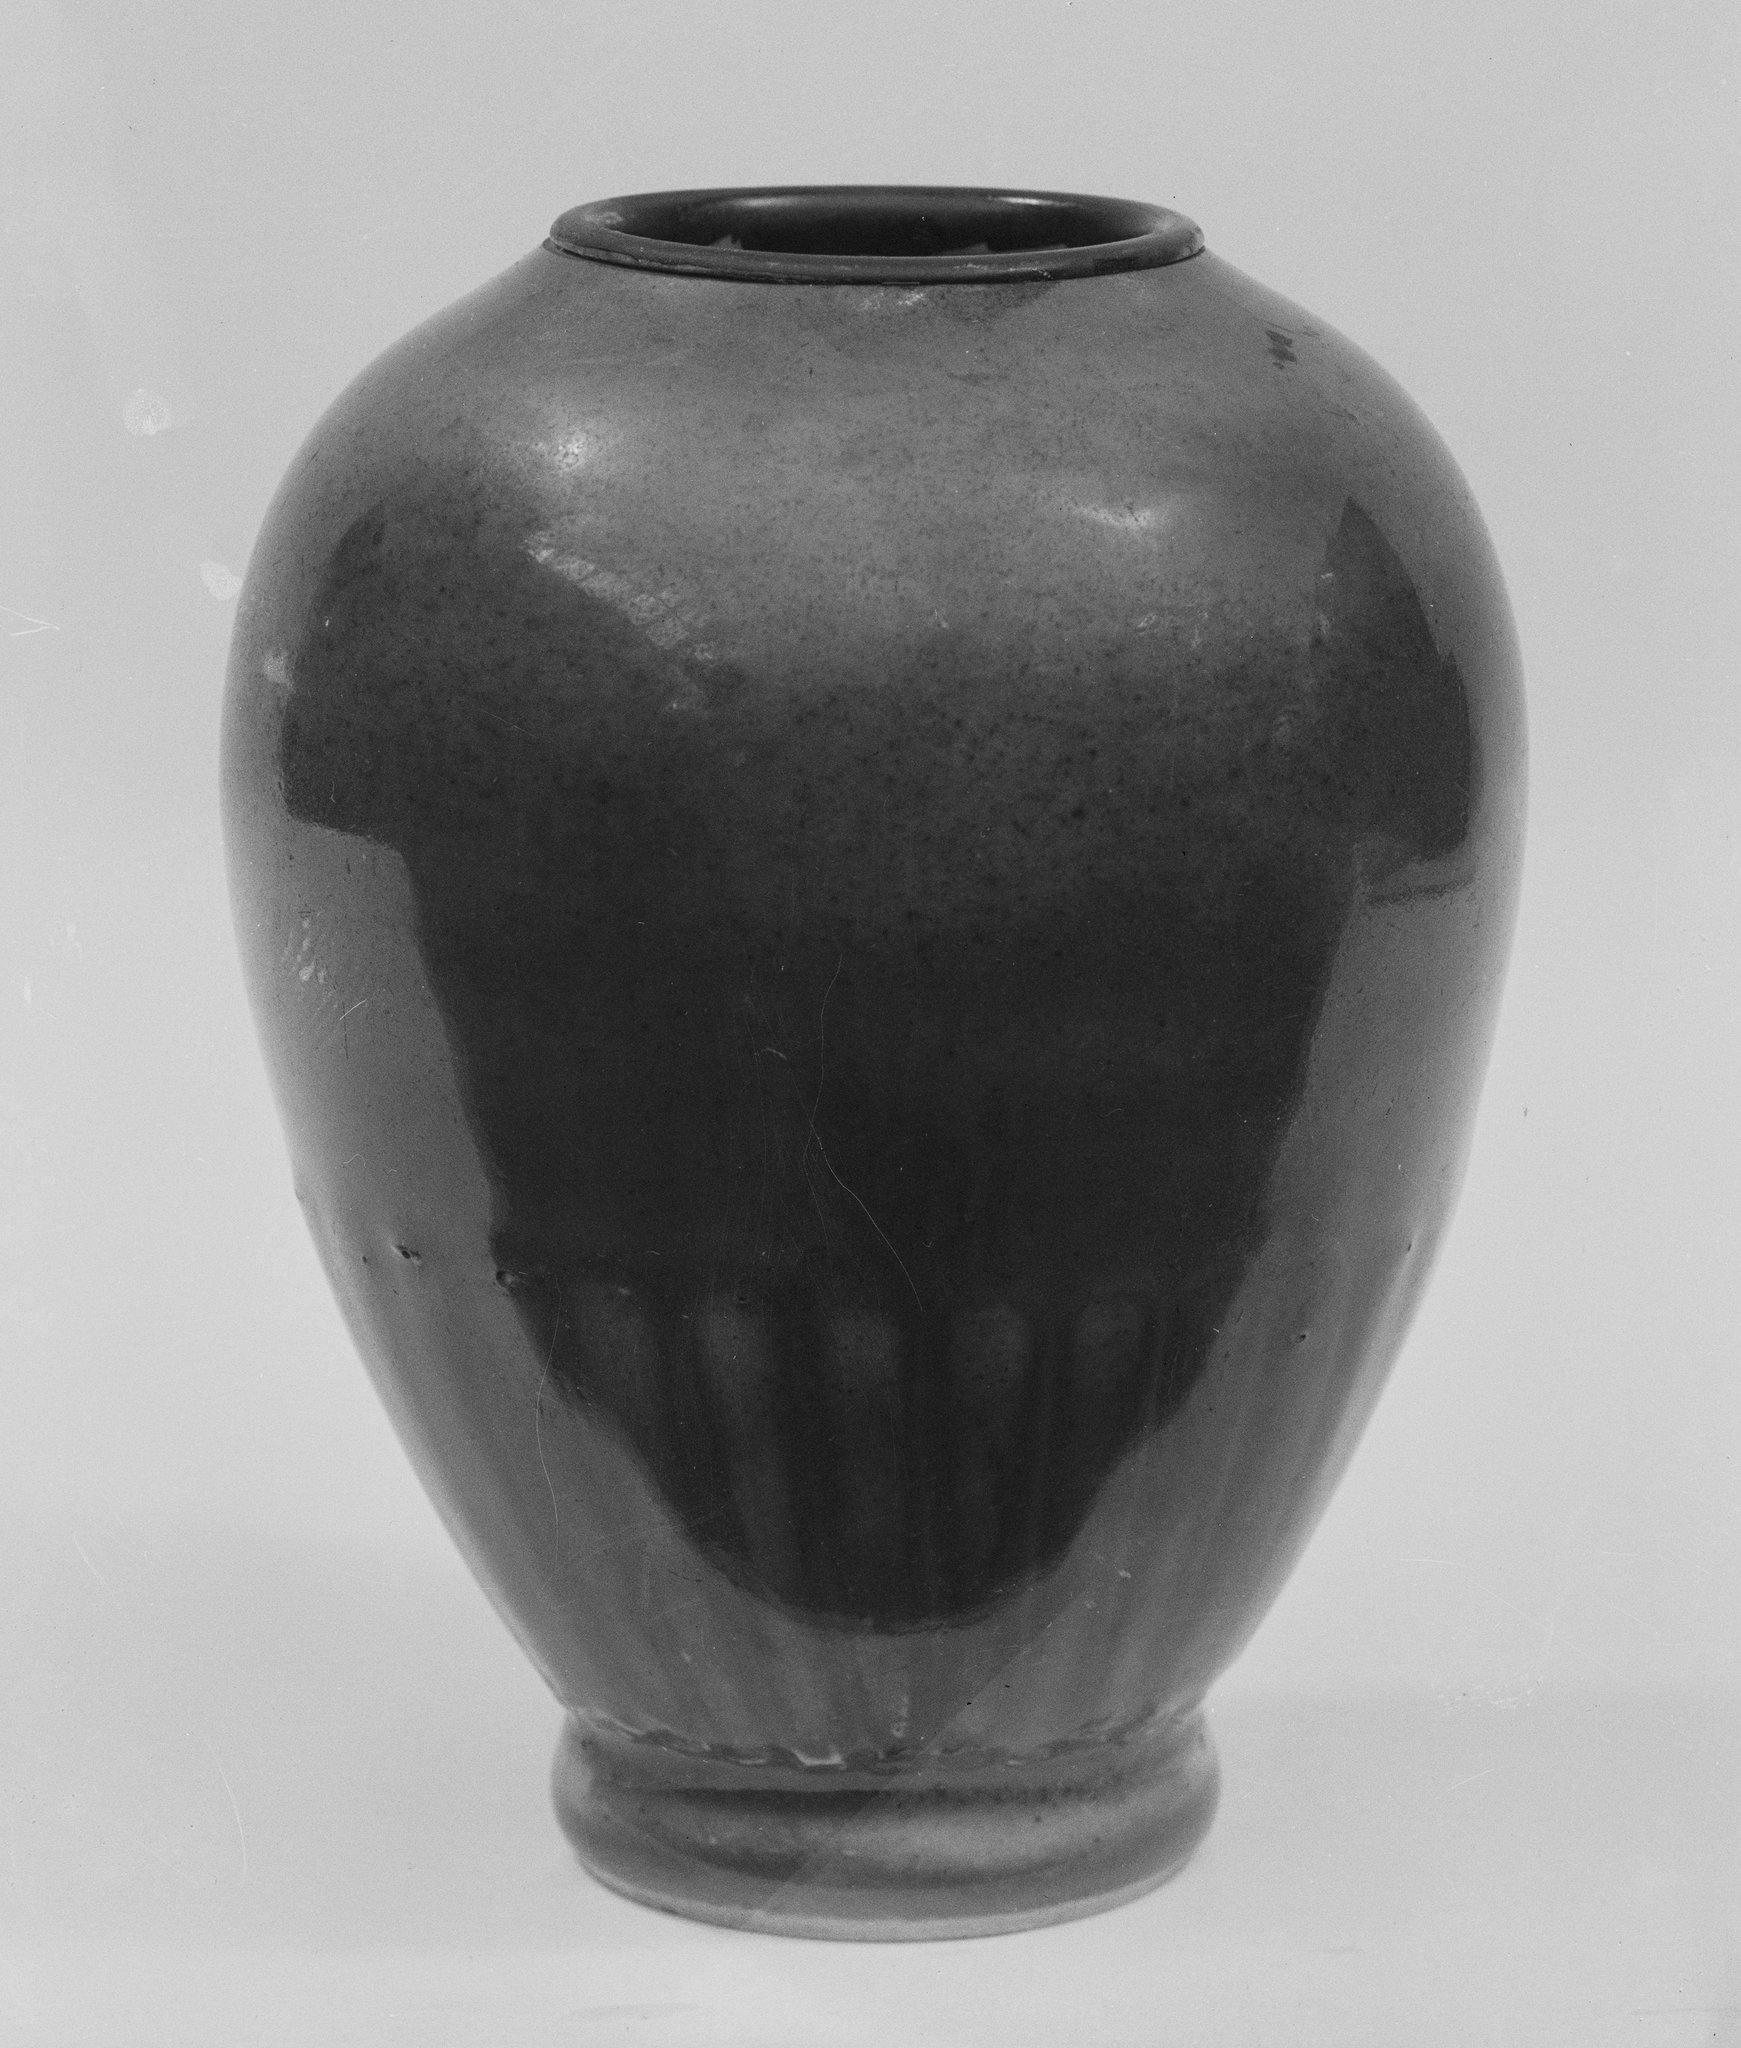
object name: coupe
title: Water Coupe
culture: chinese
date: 1662-1722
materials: glaze, porcelain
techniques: cutting